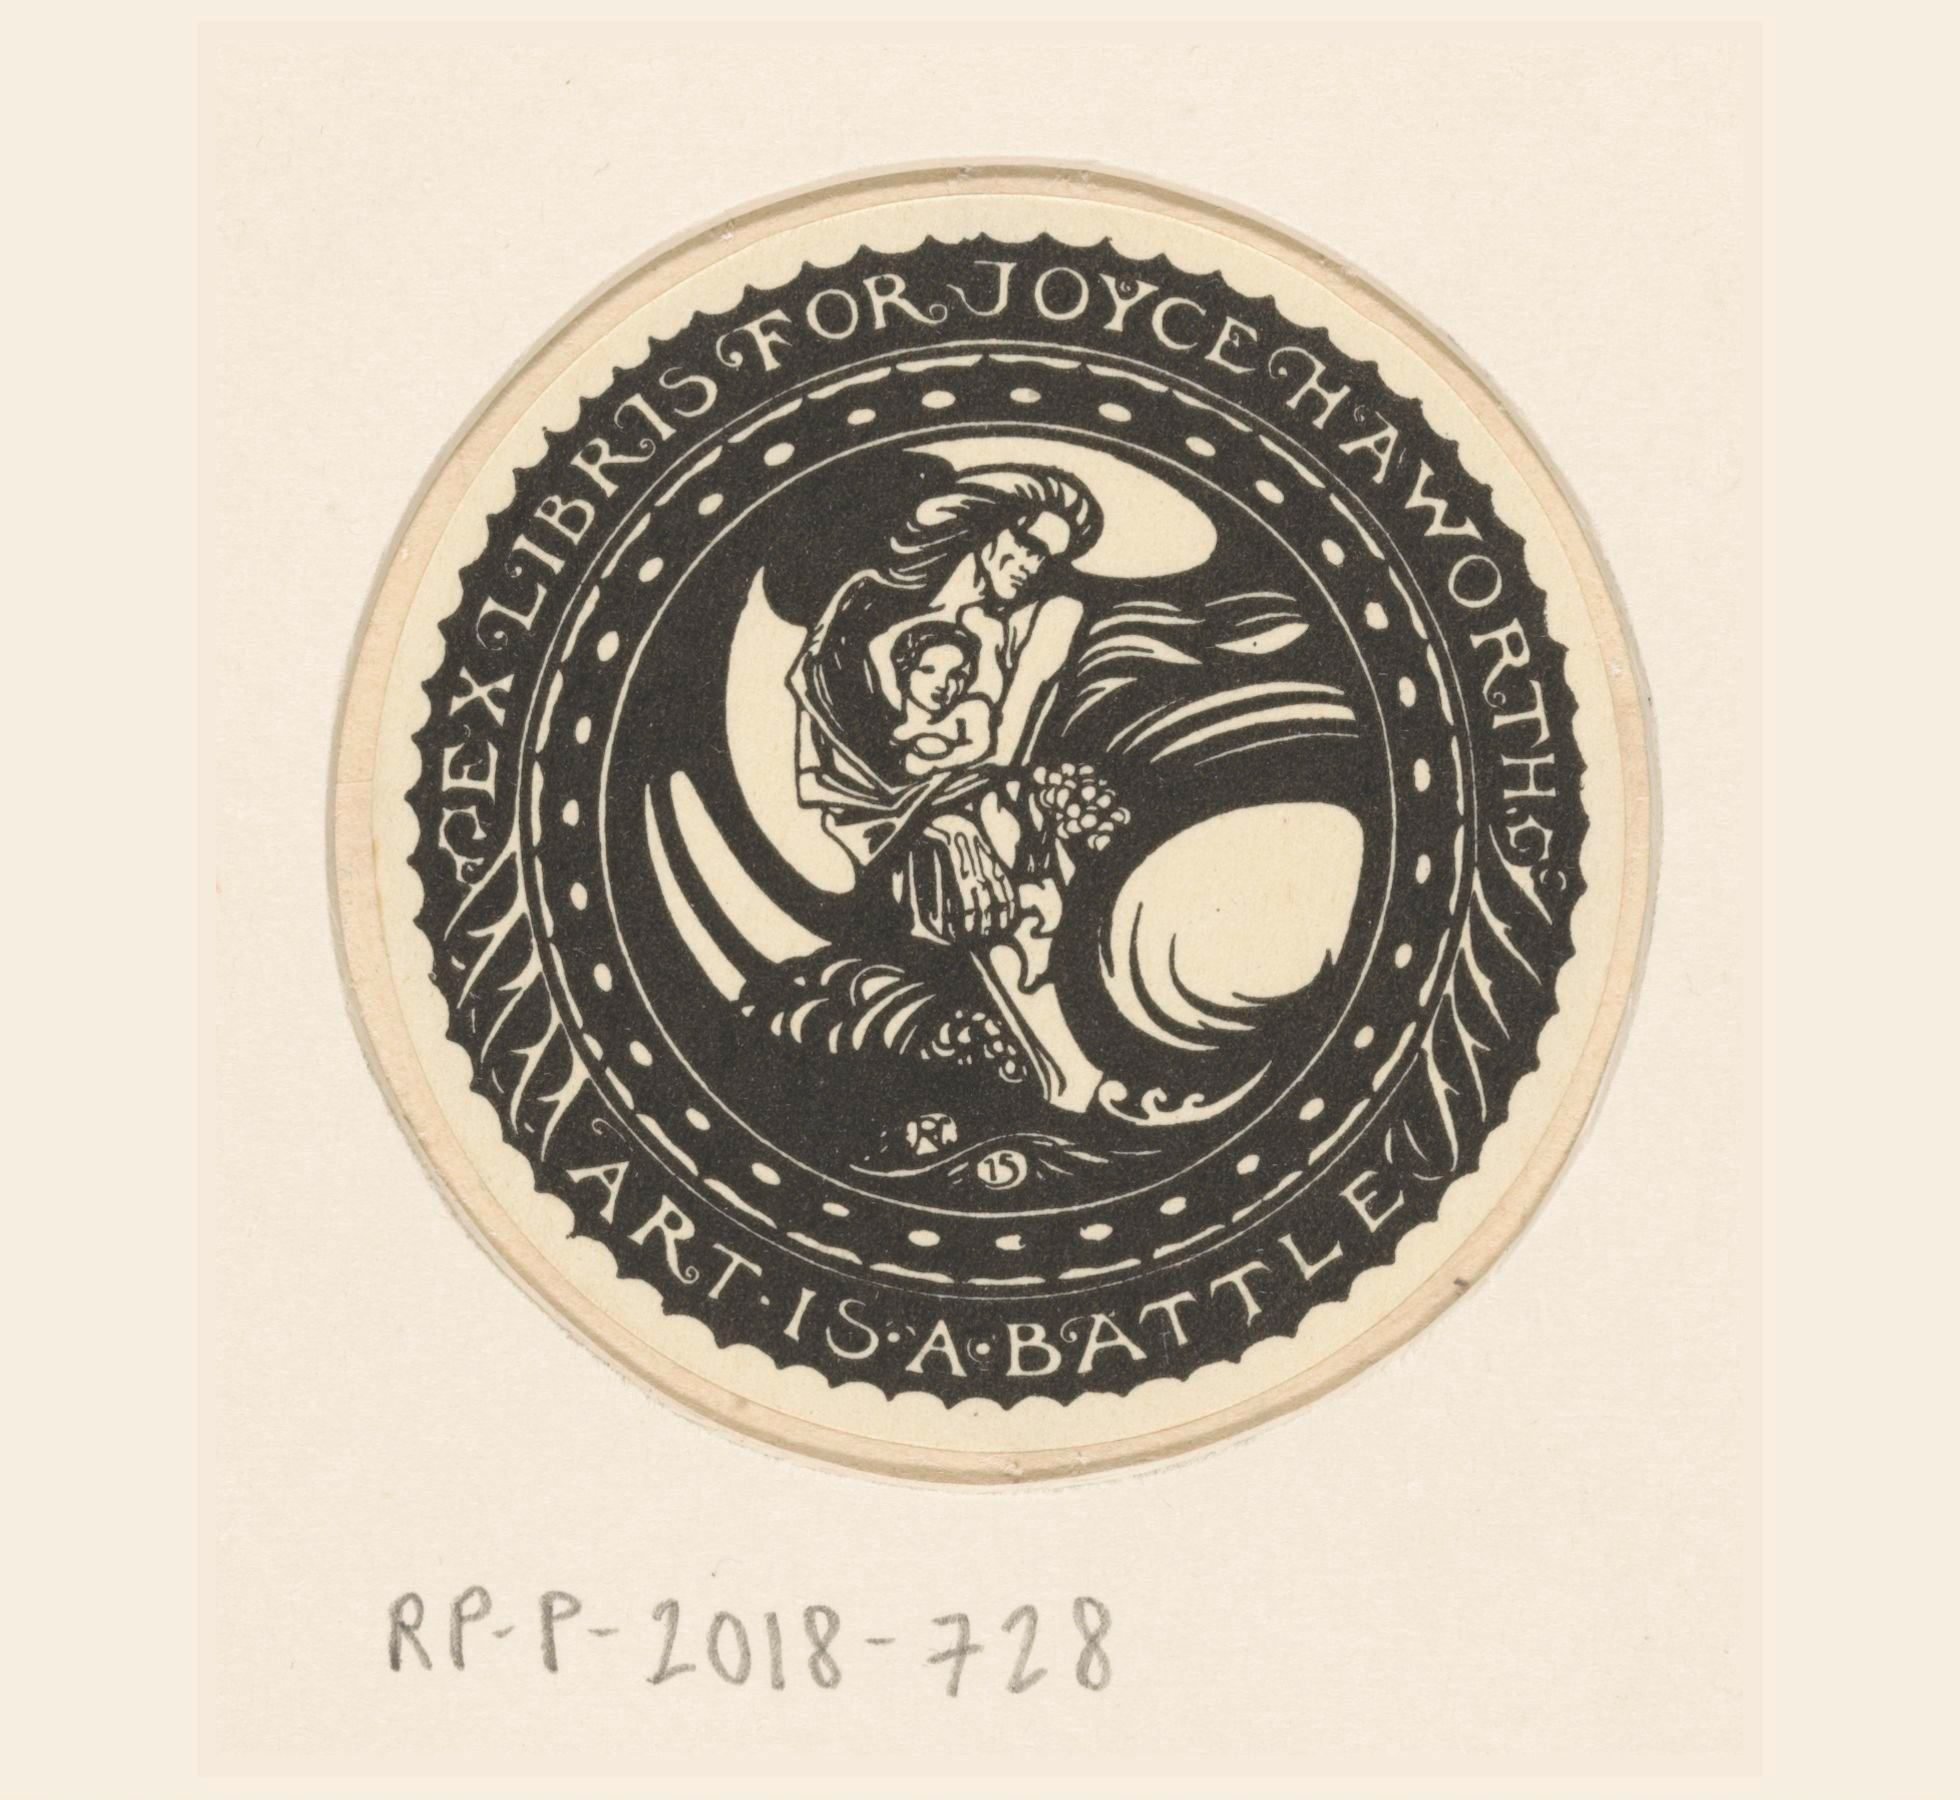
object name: print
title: Art is a battle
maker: richard nicolaüs roland holst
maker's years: 1868-1938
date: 1915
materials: paper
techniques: line block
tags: mother and child(ren), woman and child(ren) (family group)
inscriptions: number: ‘44’